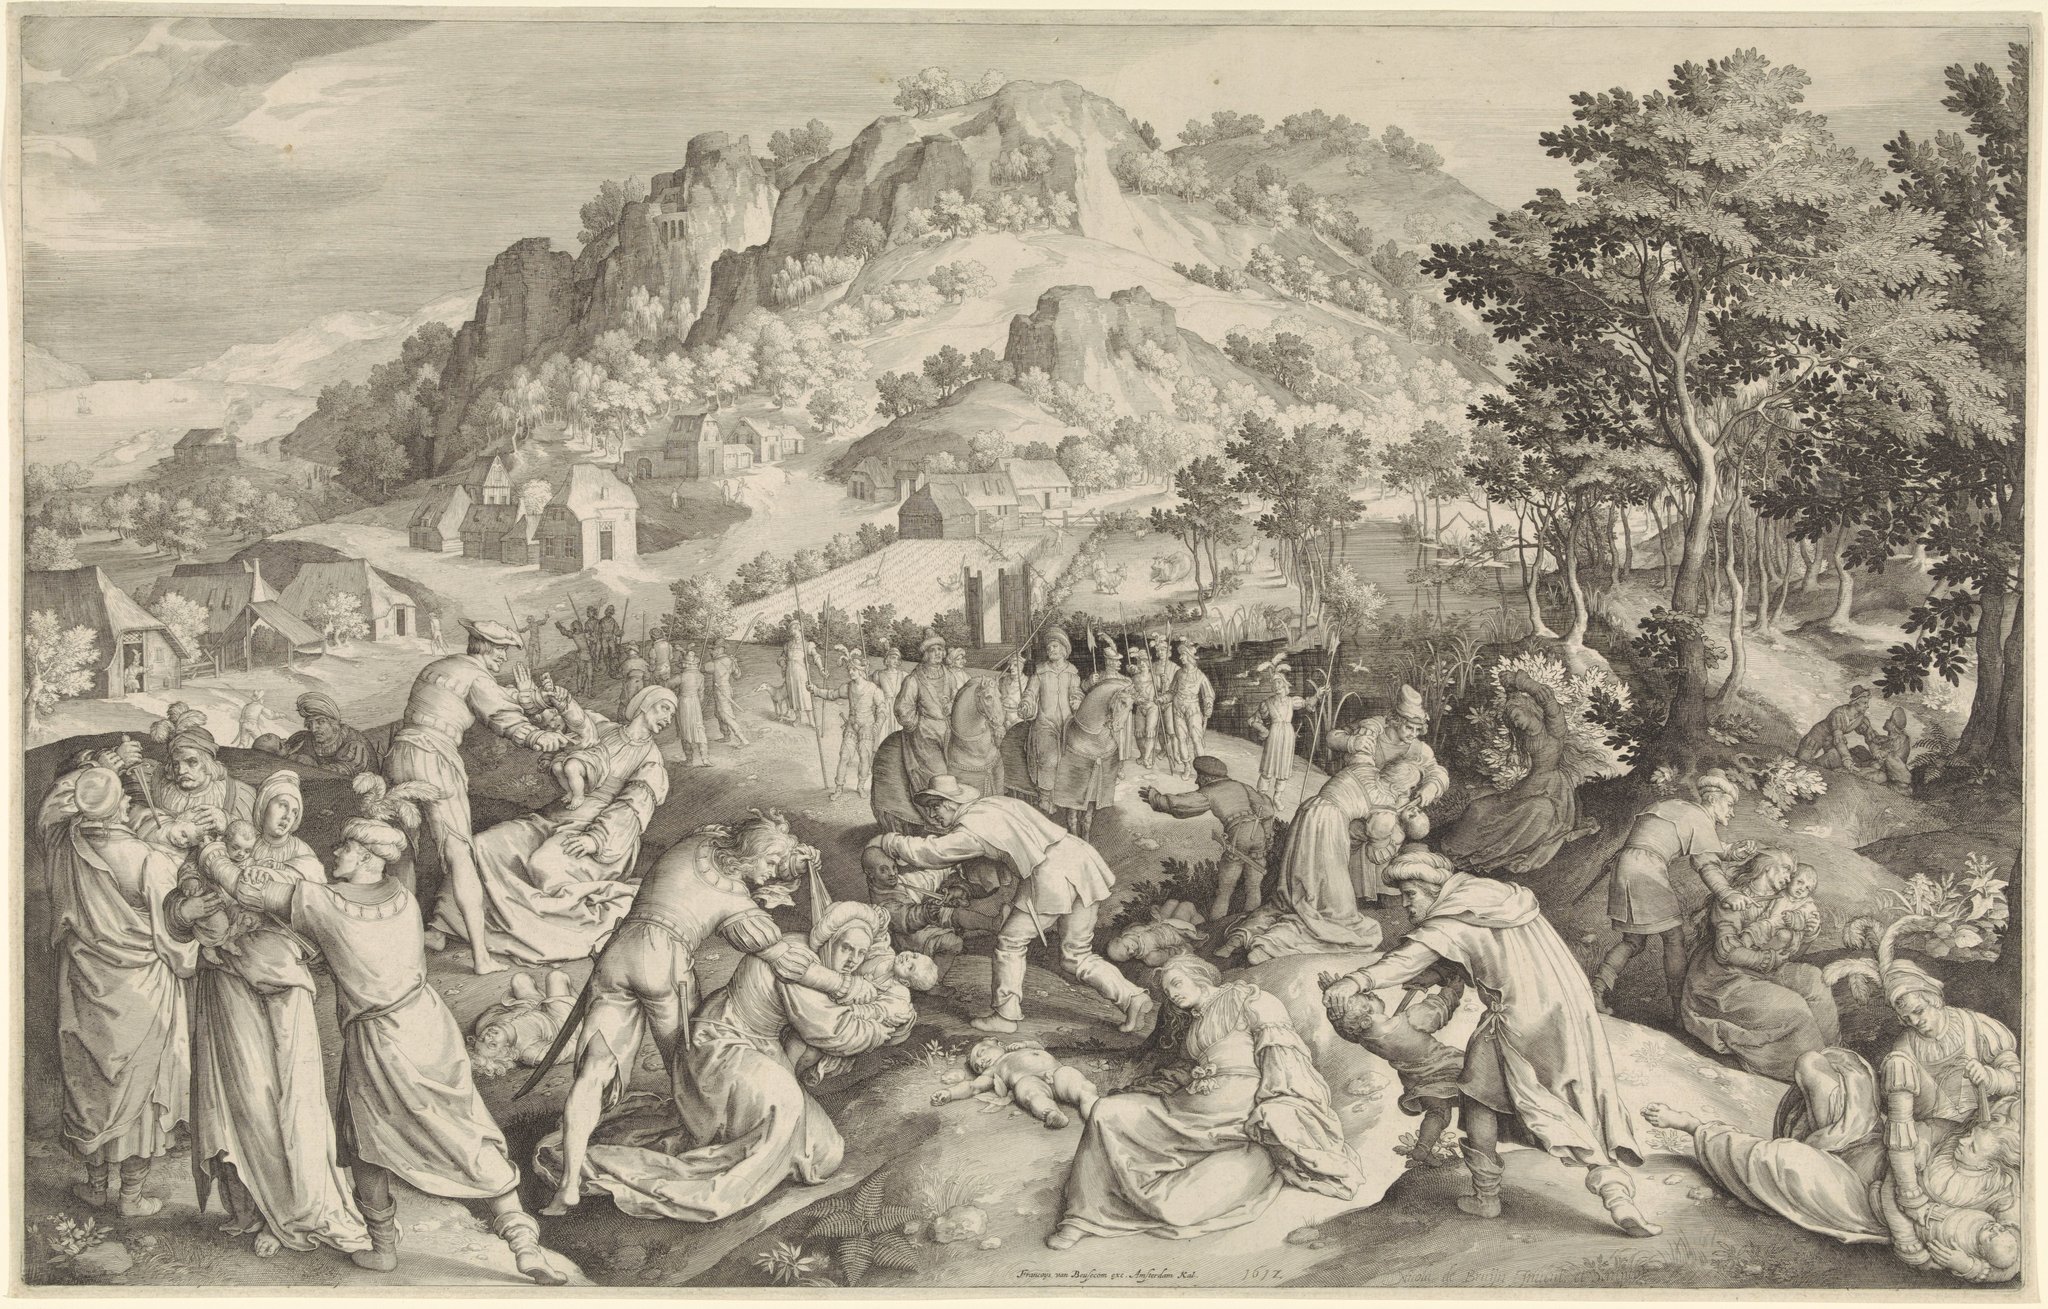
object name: print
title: Kindermoord van Bethlehem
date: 1612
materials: paper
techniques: engraving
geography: amsterdam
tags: the massacre of the innocents and the flight into egypt (matthew 2:13-23)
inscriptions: collector's mark: Lugt 2228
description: De soldaten van Herodes vermoorden alle jongens van twee jaar en jonger in Betlehem. De moeders proberen hun kinderen te beschermen.